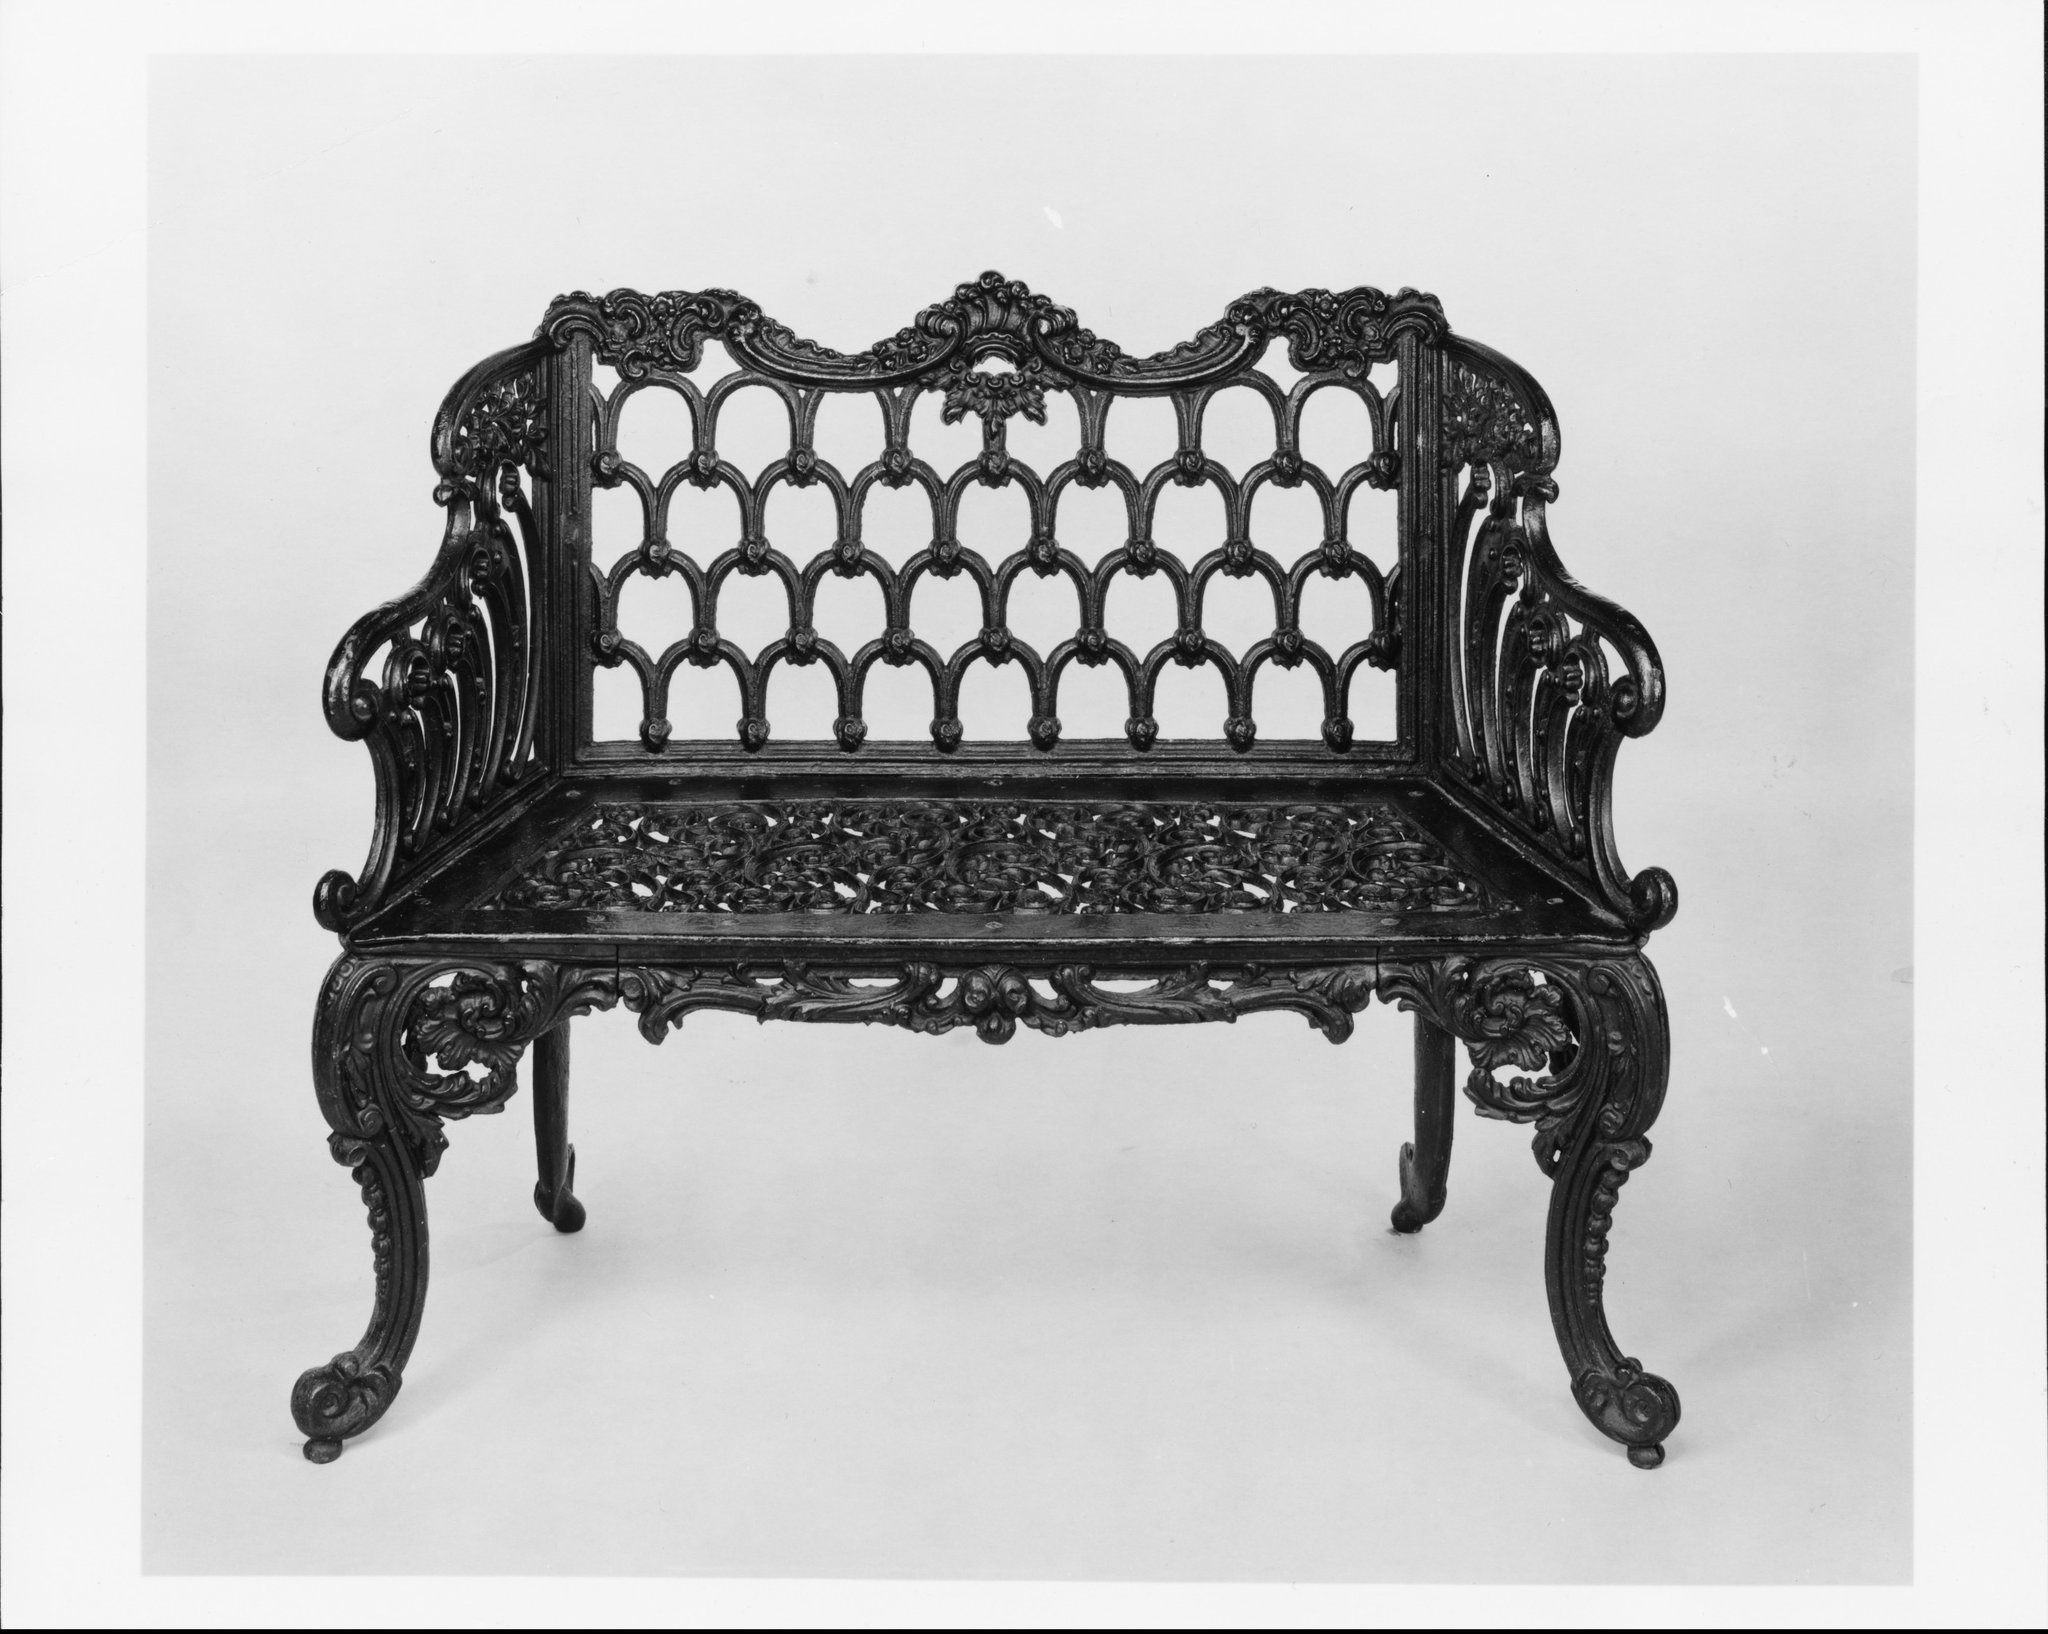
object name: garden bench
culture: american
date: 1850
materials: iron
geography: united states